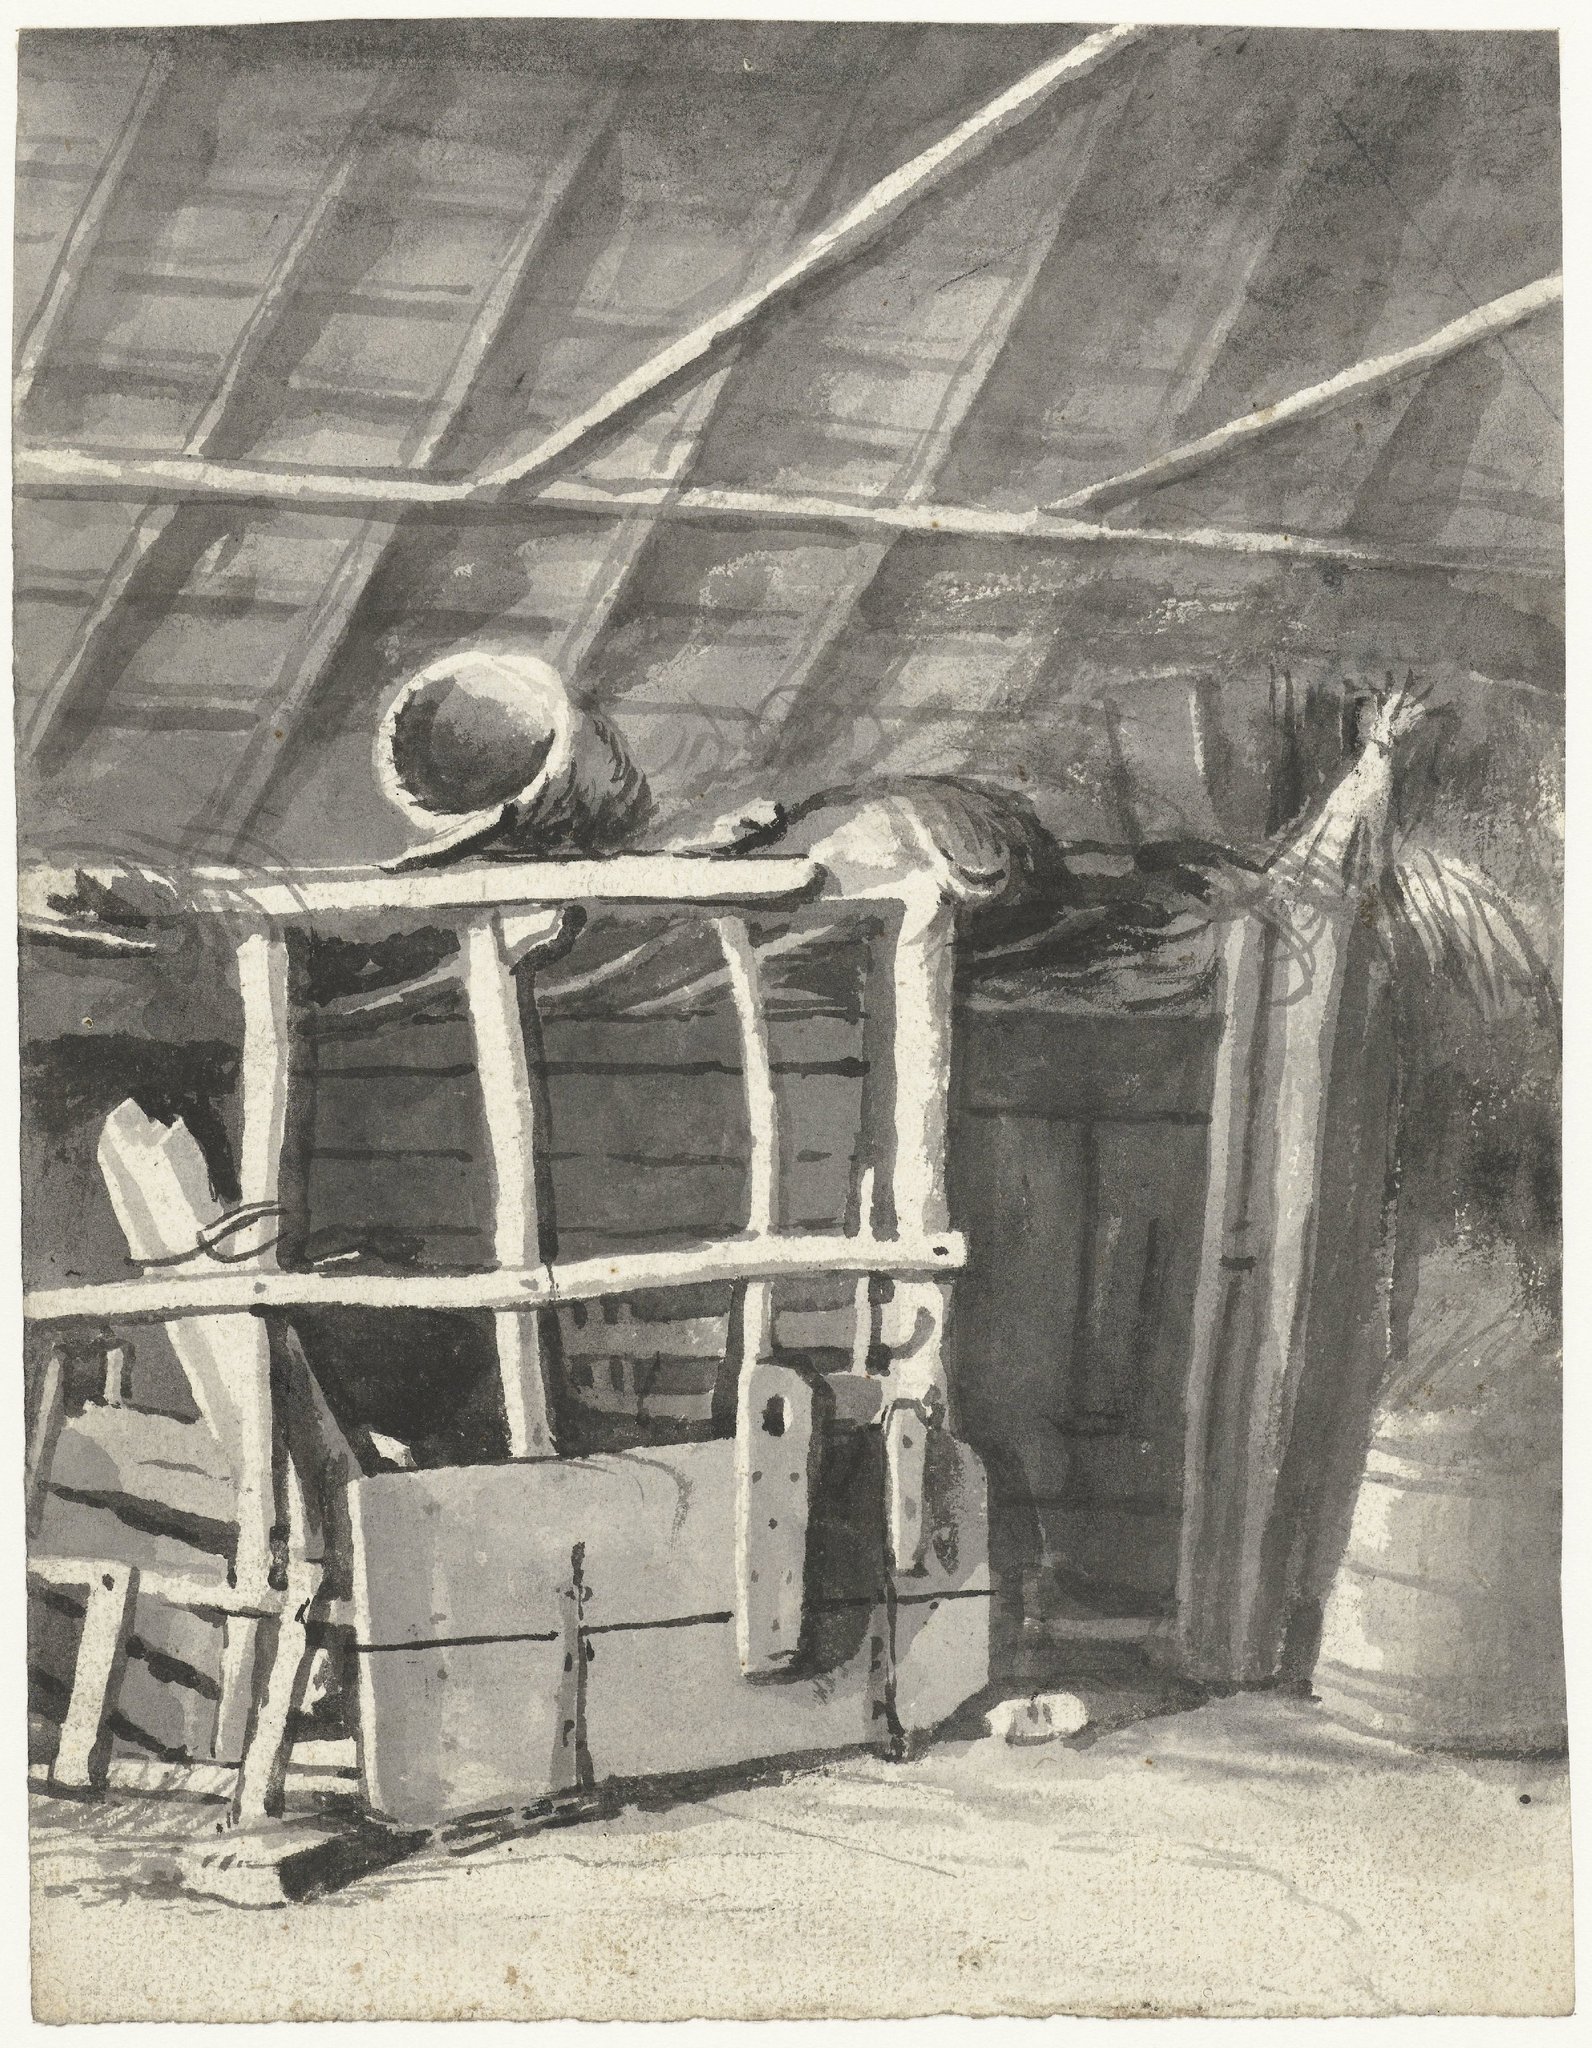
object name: drawing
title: Interieur van een stal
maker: moses ter borch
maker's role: draughtsman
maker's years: 1645-1667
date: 1660-1661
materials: ink, paper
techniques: brush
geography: zwolle